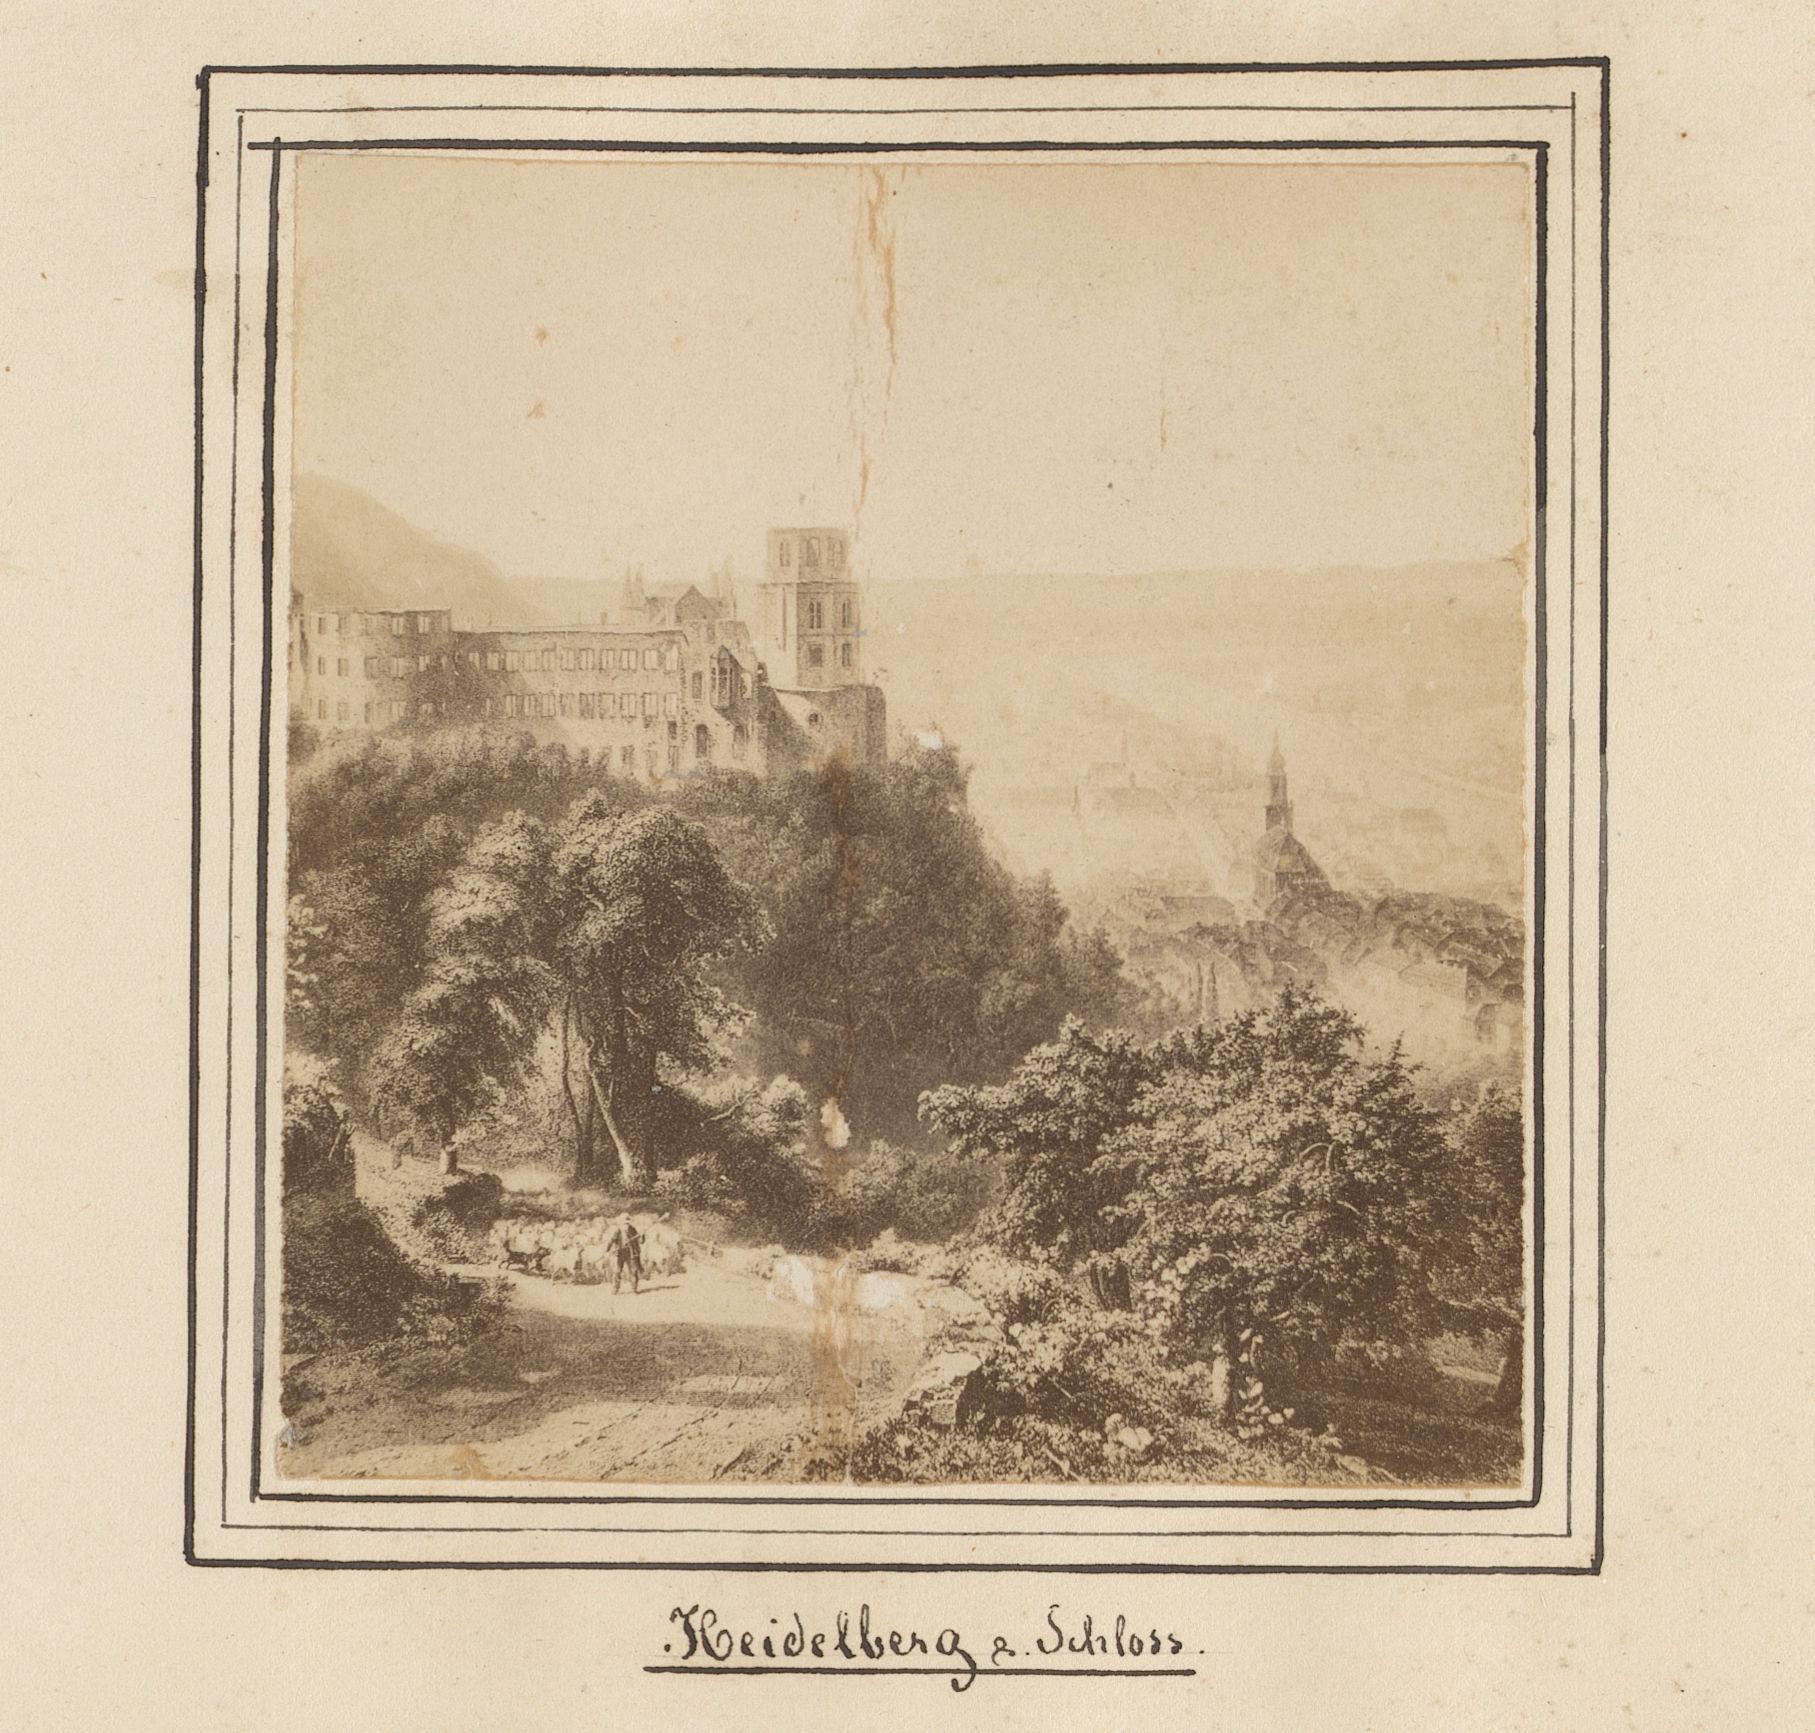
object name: photograph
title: Fotoreproductie van een schilderij van een gezicht op Heidelberg met Schloss Heidelberg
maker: Anonymous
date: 1870-1890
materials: paper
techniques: albumen print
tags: landscape with tower or castle